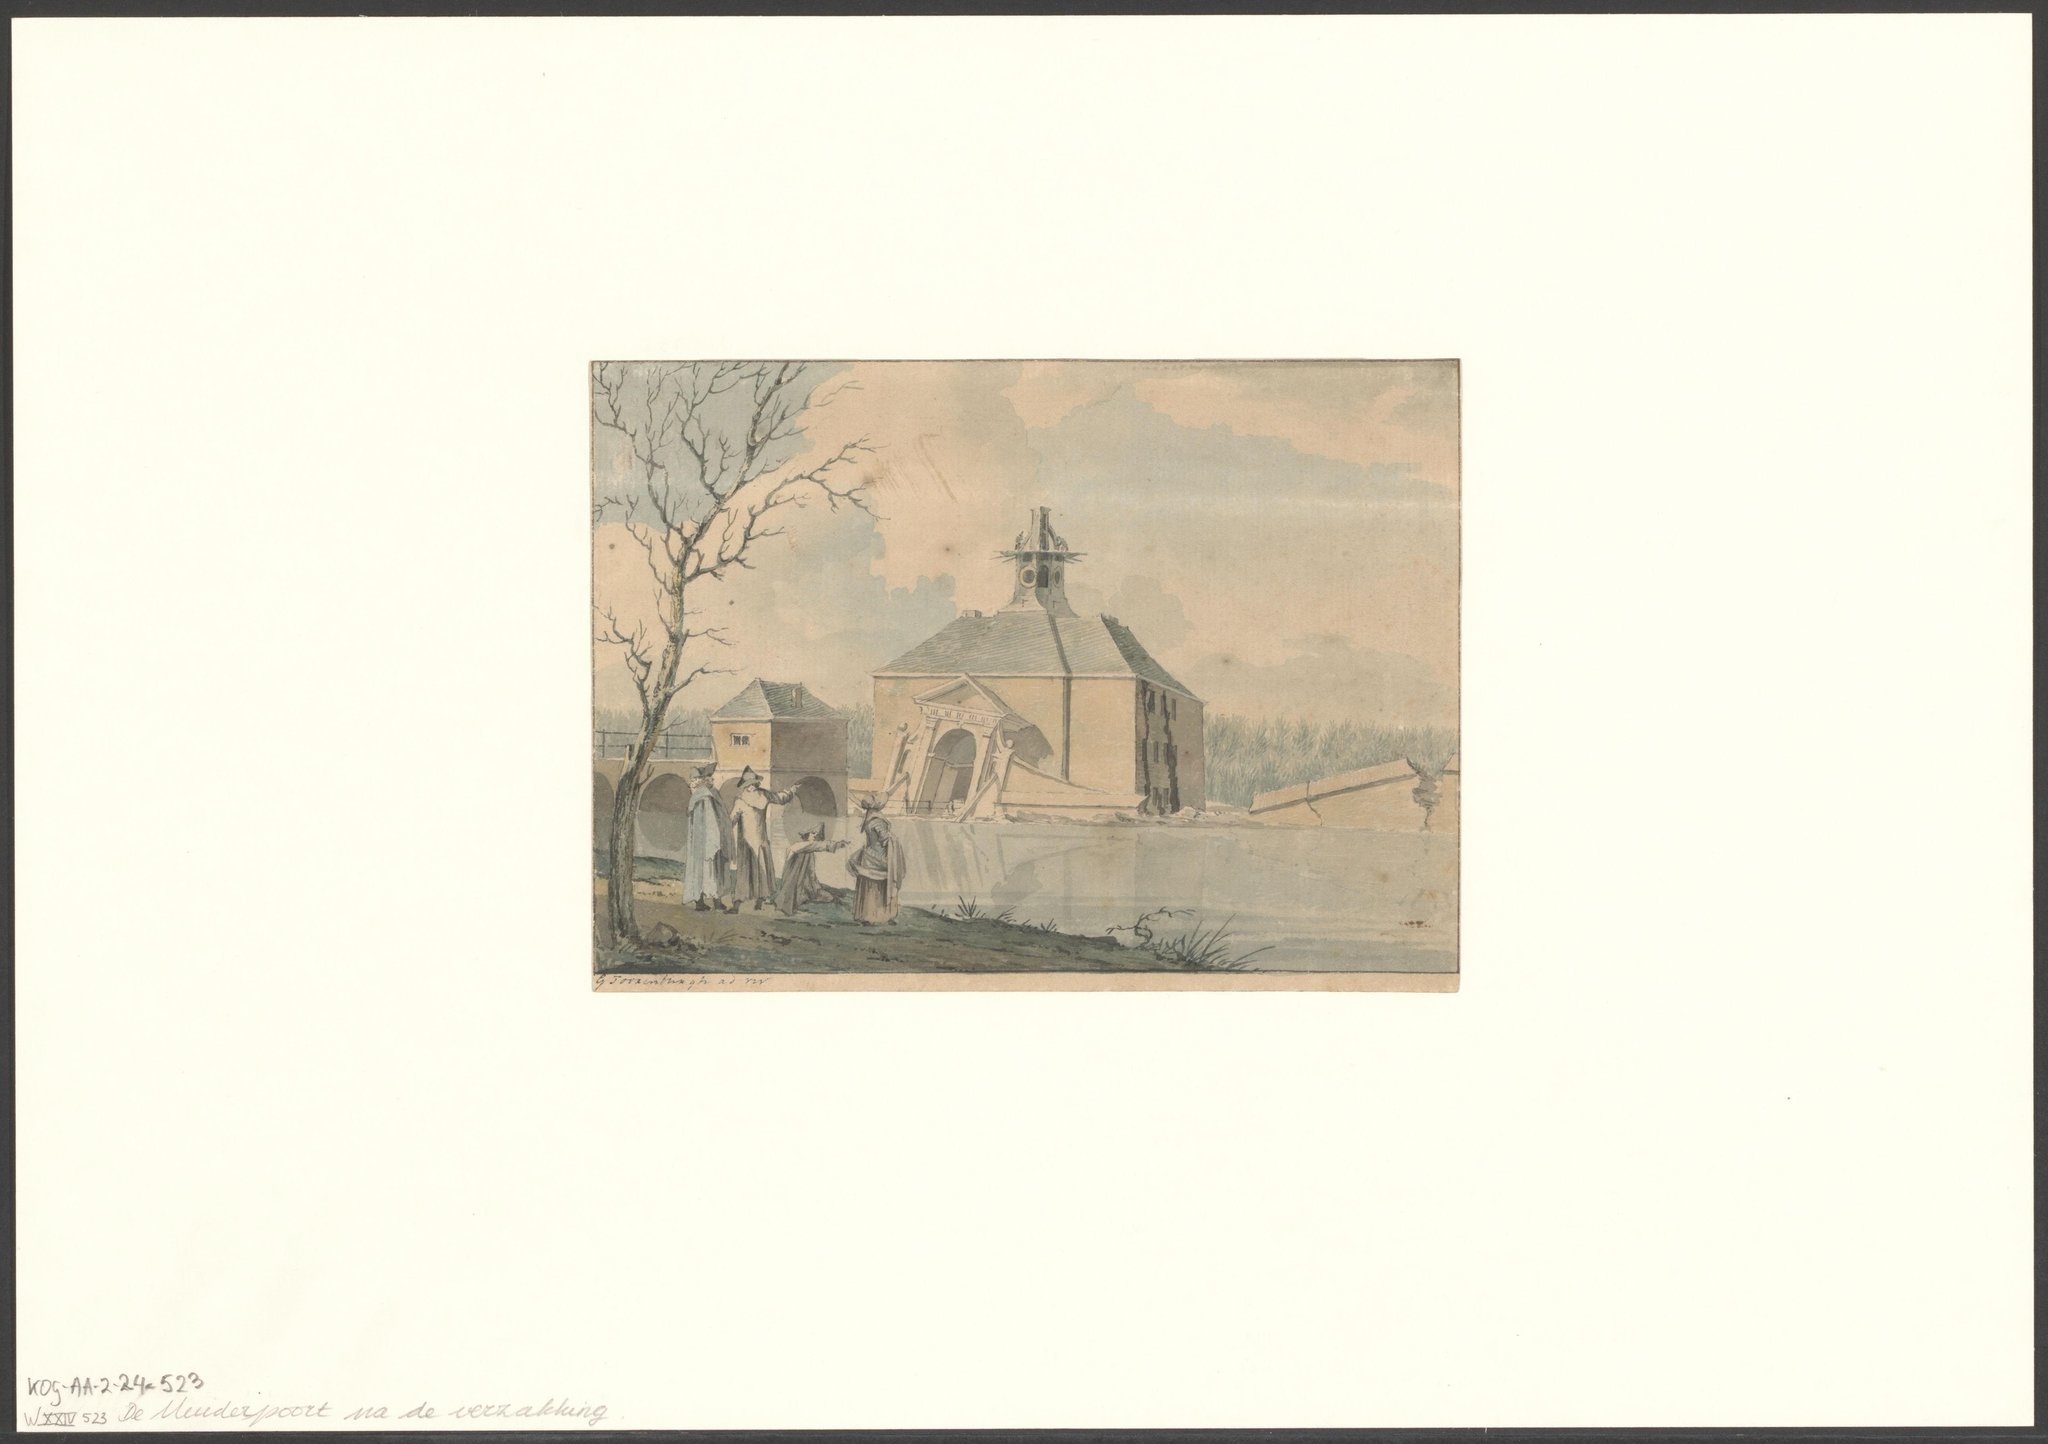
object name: drawing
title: Gezicht op de eerste Muiderpoort na de verzakking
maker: gerrit toorenburgh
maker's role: draughtsman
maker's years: 1732-1785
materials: ink, paper, watercolor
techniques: brush, pen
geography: amsterdam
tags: city-view in general; 'veduta', collapsing building, city-gate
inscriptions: signature: ‘G Toorenburgh ad viv’, inscription: ‘de Muyder Poort tot Amsterdam soo als / desche zig vertoonden na tusschen den / 29 & 30 january des nagts circa / 16 voeten in de Grond gesakt / te syn’, collector's mark: Lugt 800a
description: Tekening binnen de Atlas Van Eck ingedeeld op wijknummer 24.